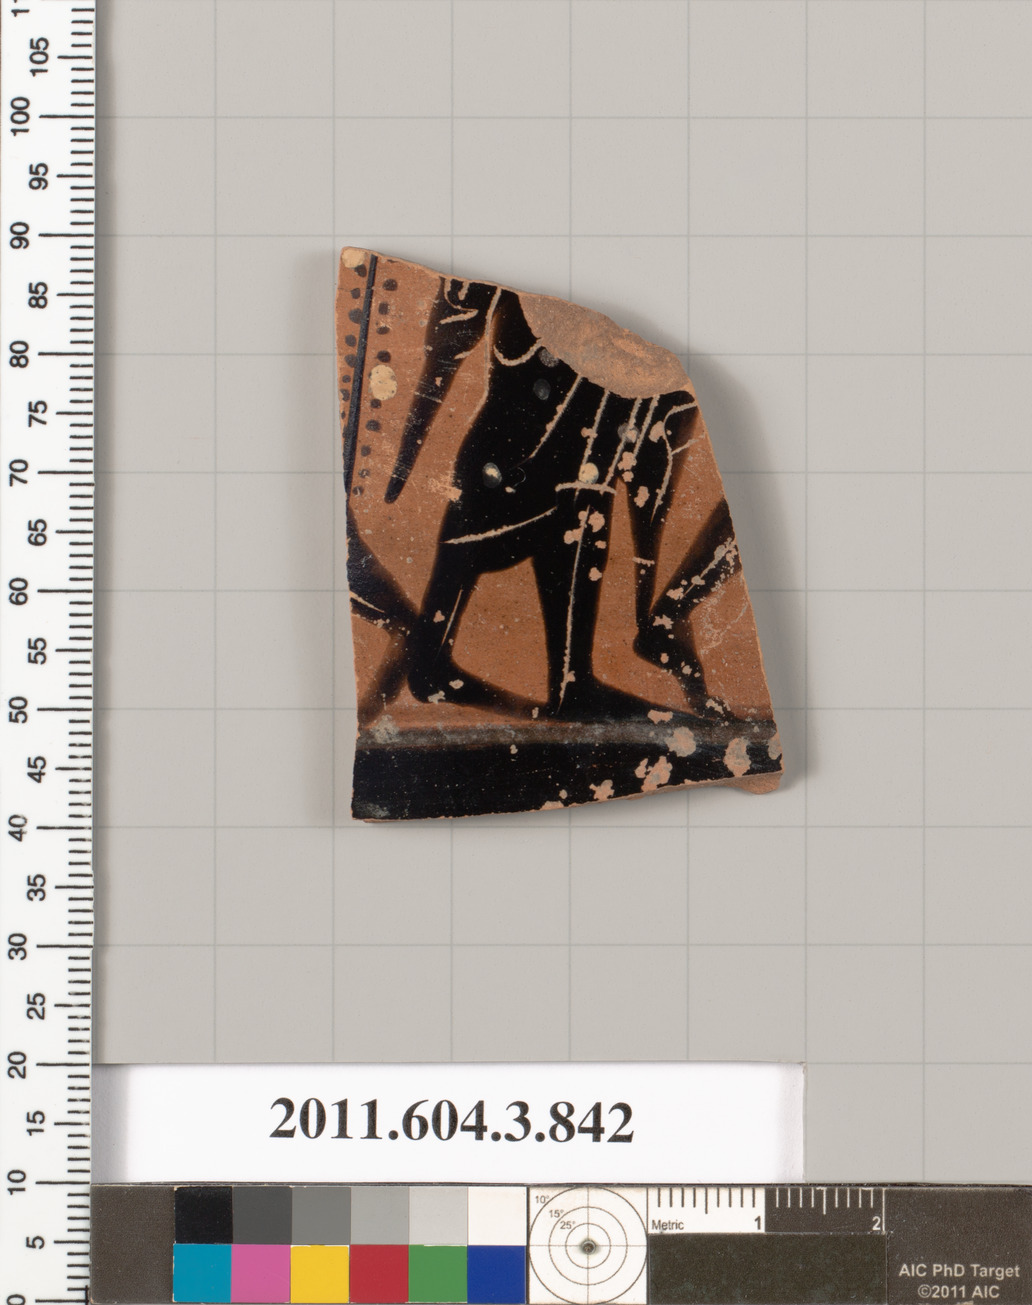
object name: lekythos fragment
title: Terracotta fragment of a lekythos (oil flask)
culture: greek, attic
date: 534-501 BCE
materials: terracotta